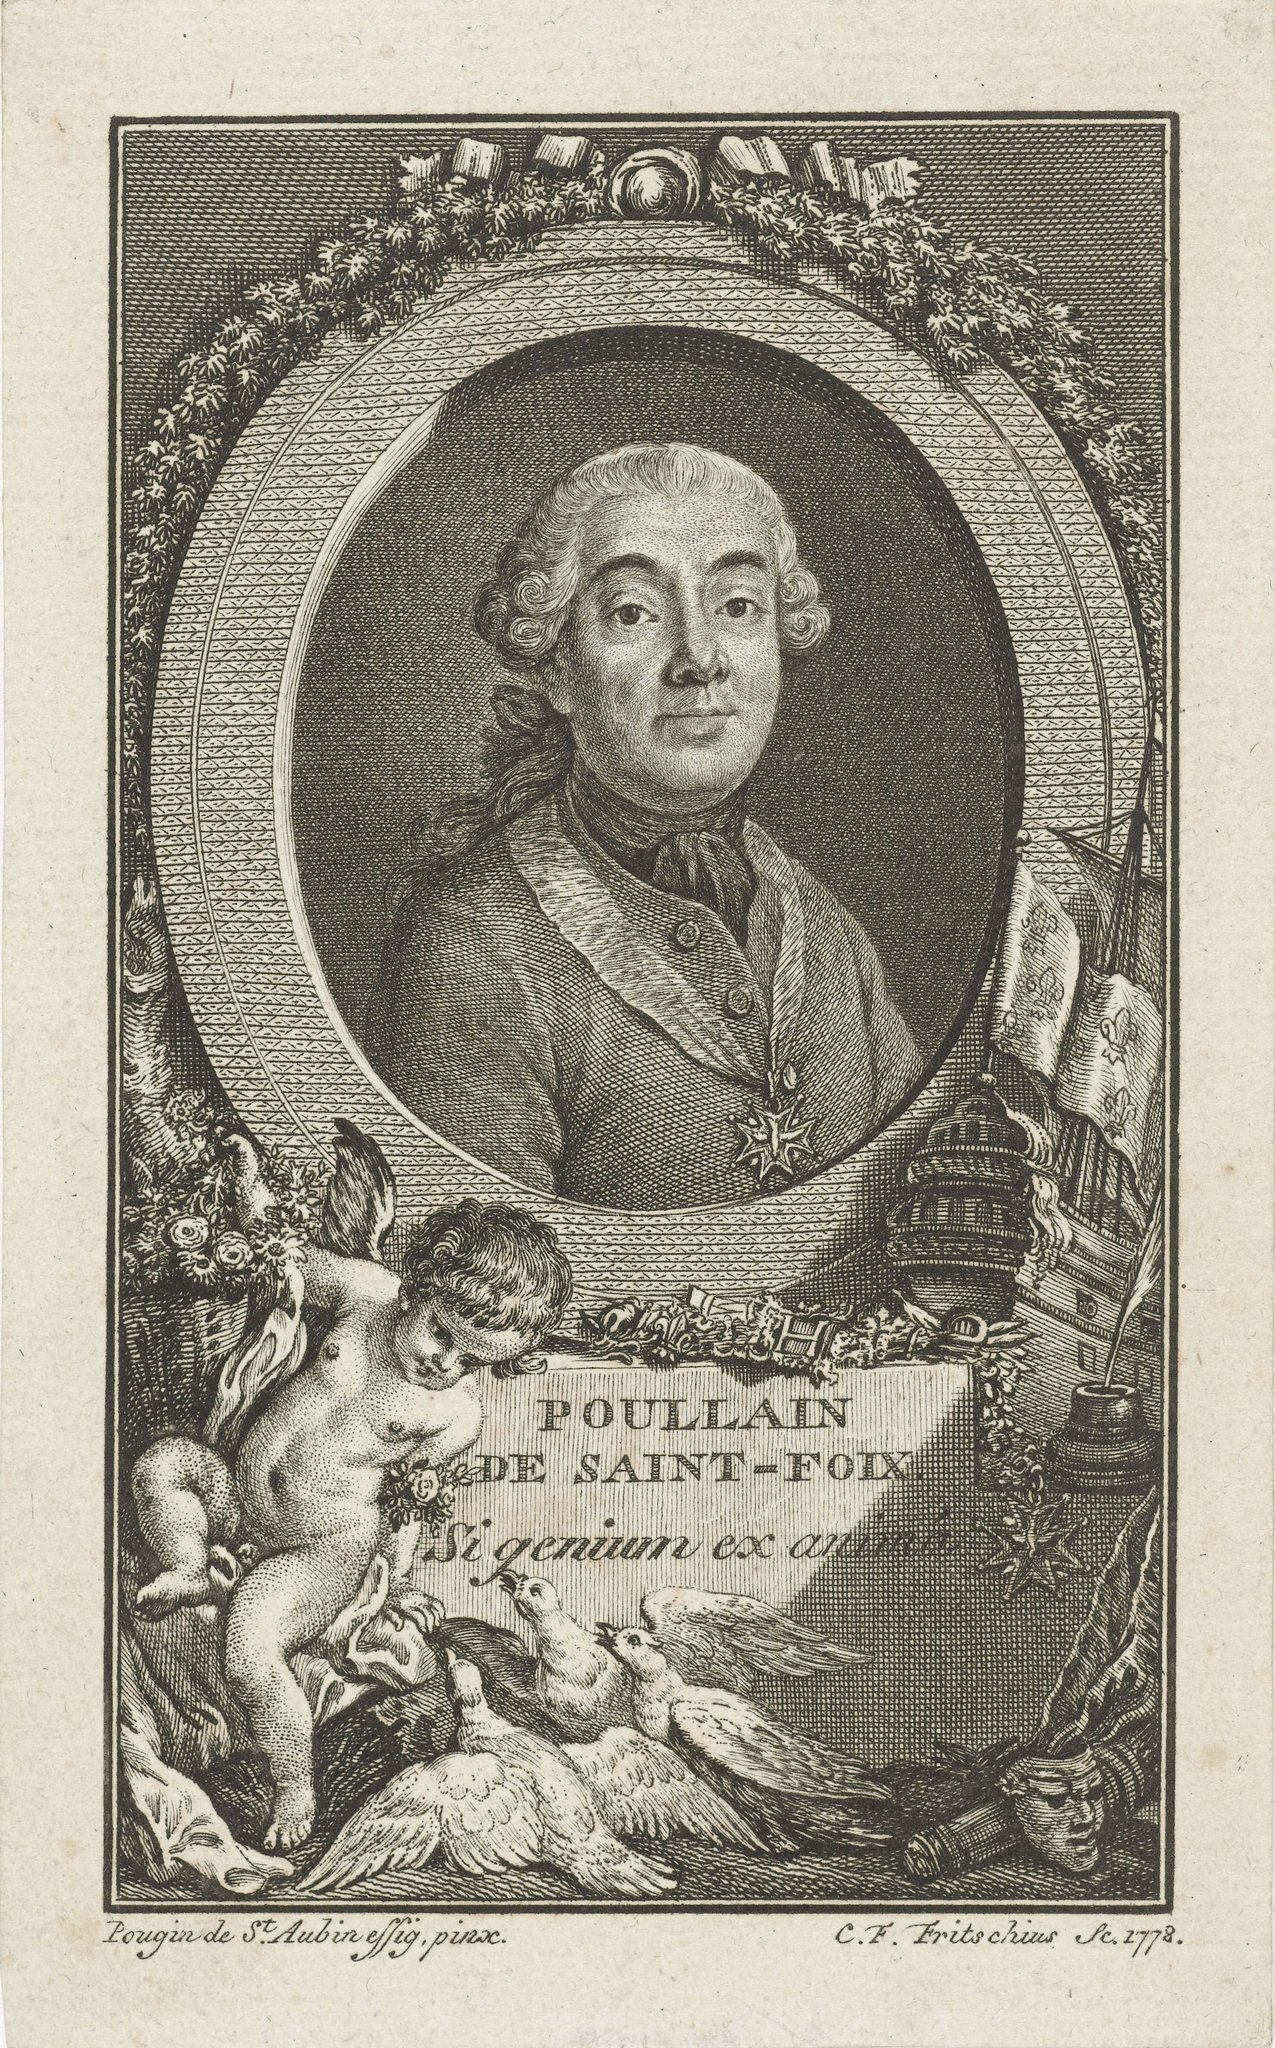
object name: print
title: Portret van Germain-François Poullain de Saint-Foix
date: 1778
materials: paper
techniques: engraving, etching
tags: rennes, schrijver, germain-françois poullain de saint-foix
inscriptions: collector's mark: Lugt 2228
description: Portretbuste in ovaal naar rechts van Germain-François Poullain de Saint-Foix, blootshoofds. Om zijn hals hangt een lint met het kruis van de orde van de Heilige Geest. De massieve ovale lijst is versierd met takken en een lint en staat op een sokkel waarop de naam van de geportretteerde en een Latijnse spreuk staat. Rechts van het portret zijn een zeilschip, een pot met schrijfveer en een Maltezer kruis aan een ketting afgebeeld. Geheel op de voorgrond aanschouwt een putto met bloemenmand drie duiven die voor hem staan. Rechts op de grond ligt een masker.